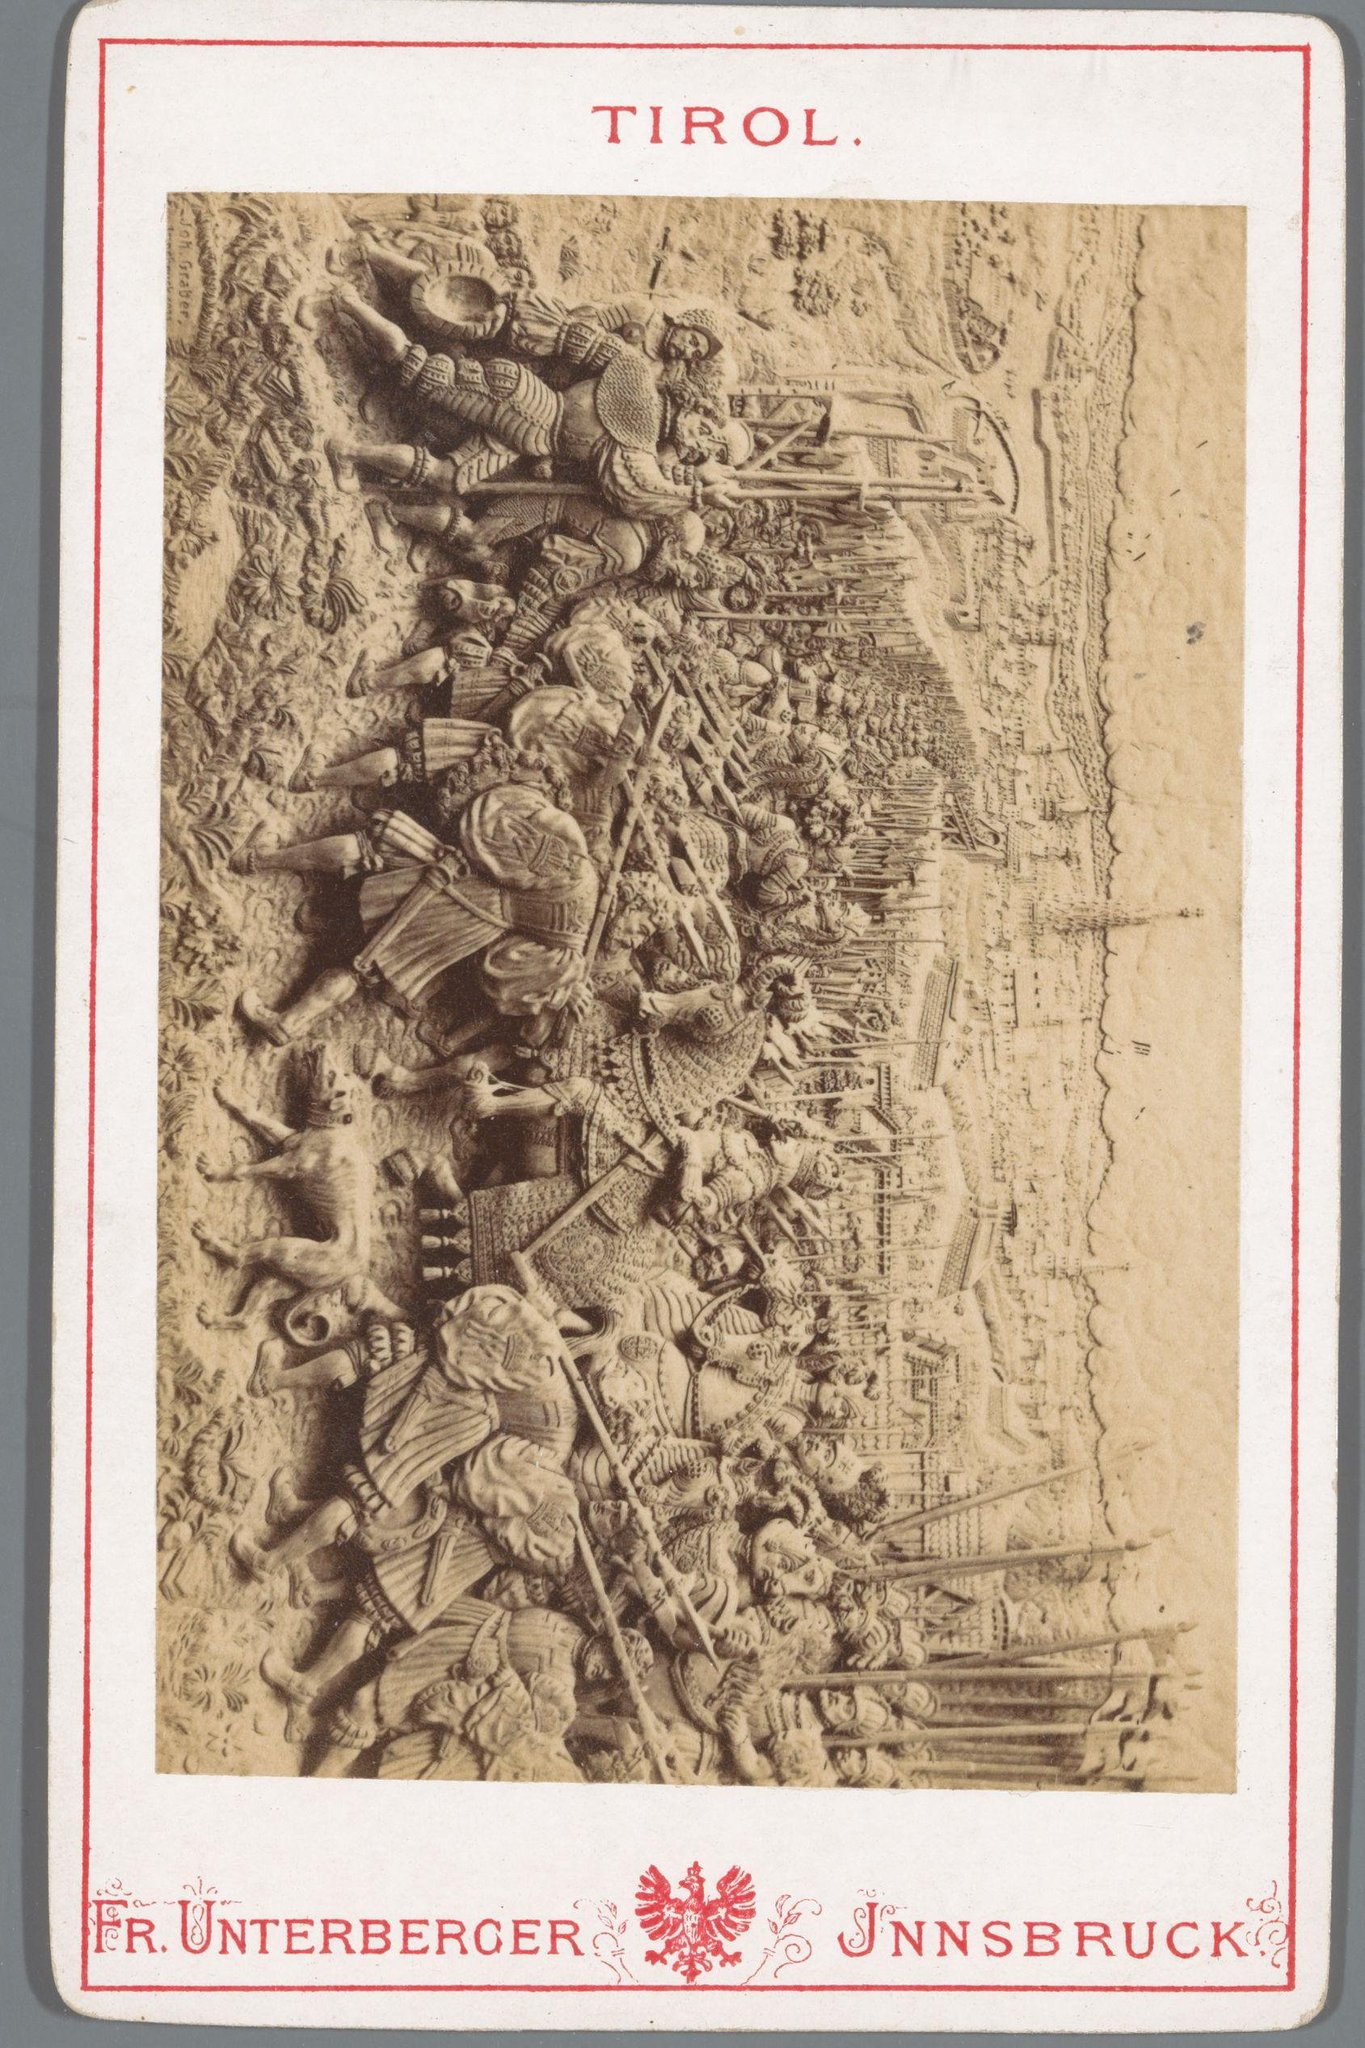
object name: photograph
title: Reliëf op de tombe van keizer Maximiliaan I: intocht in Wenen, 1490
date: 1855-1867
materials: cardboard, paper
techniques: albumen print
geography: innsbruck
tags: grave, tomb, march into the conquered place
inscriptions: inscription: ‘6.’, number: ‘19.’